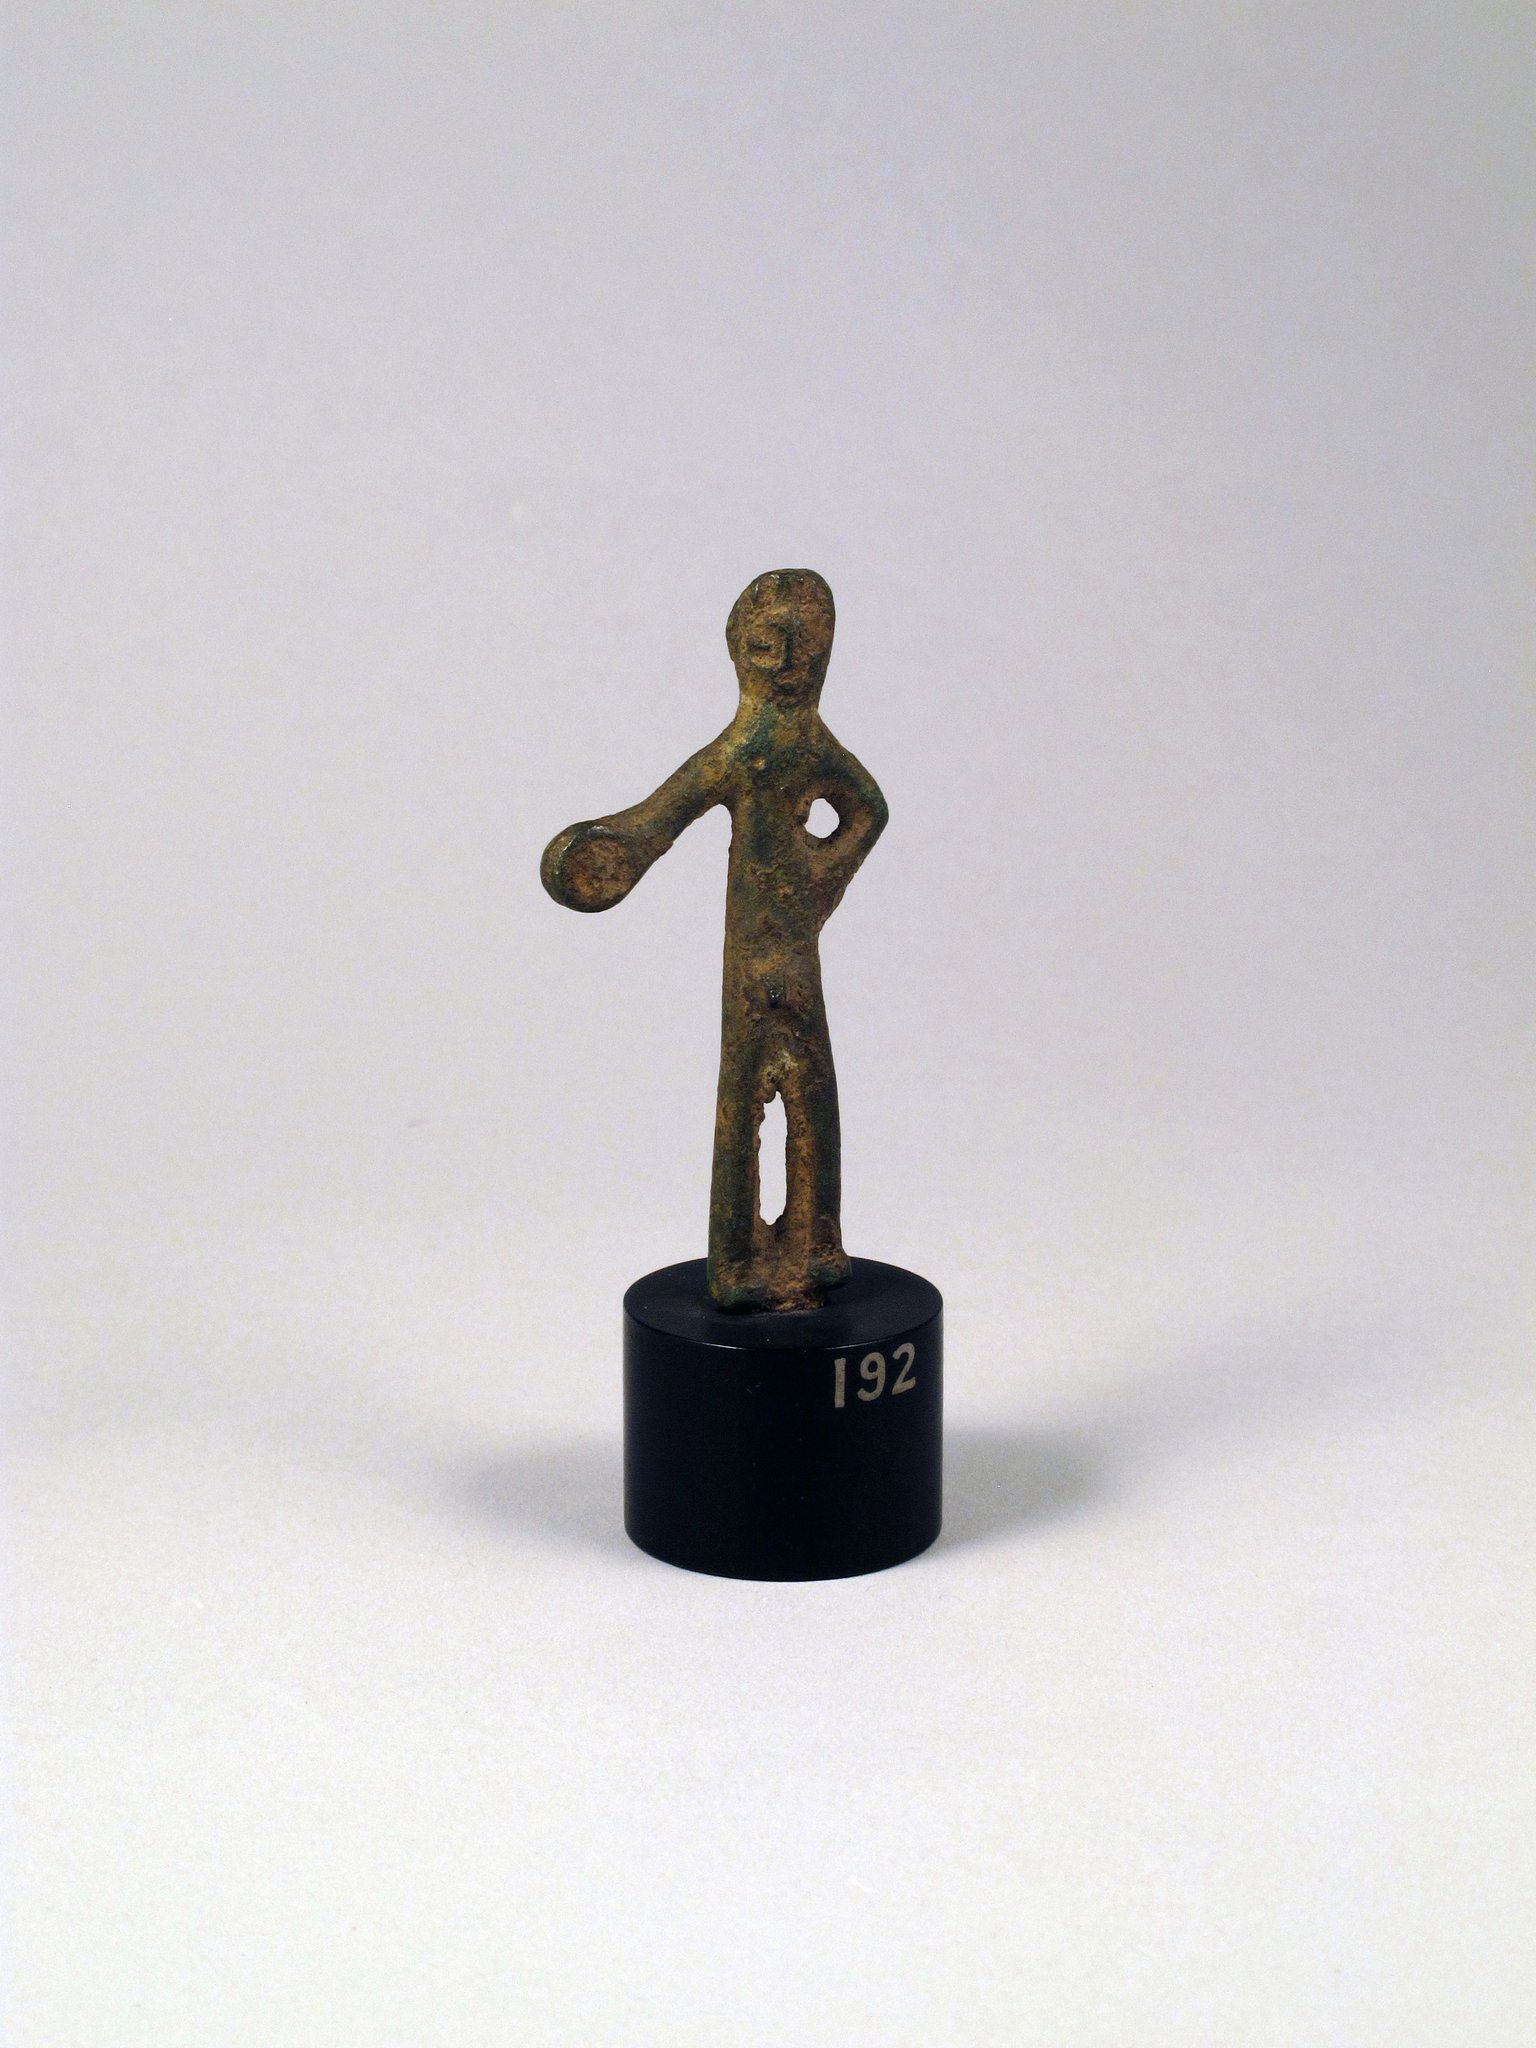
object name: statue of a man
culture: italic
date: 501-600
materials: bronze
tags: men